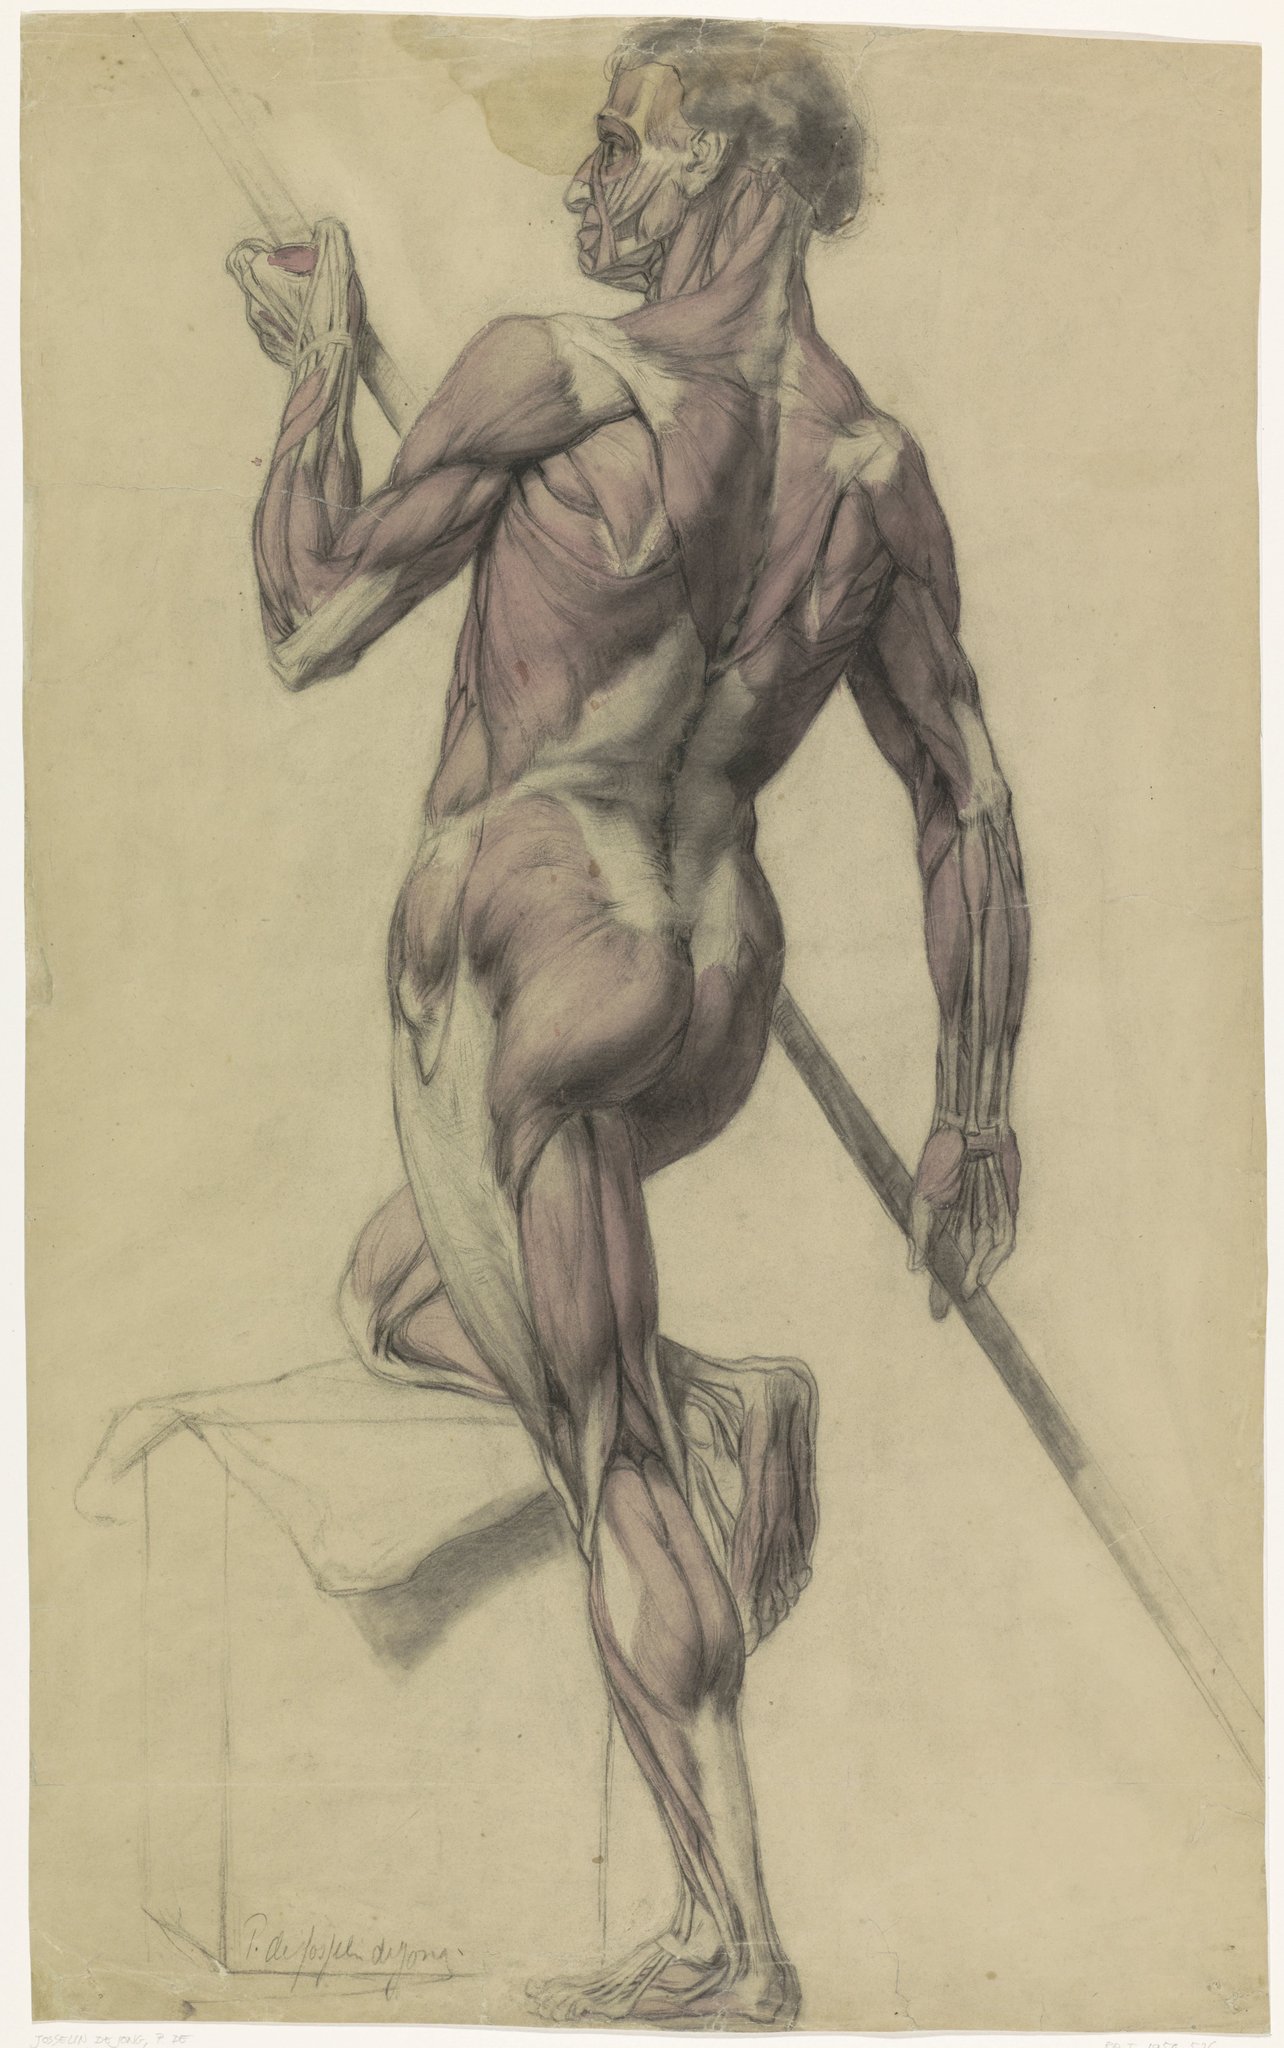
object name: drawing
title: Anatomische studie van een mannelijk lichaam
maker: pieter de josselin de jong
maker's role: draughtsman, painter, print maker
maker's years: 1861-1906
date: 1871-1906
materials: chalk, paper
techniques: brush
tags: muscles